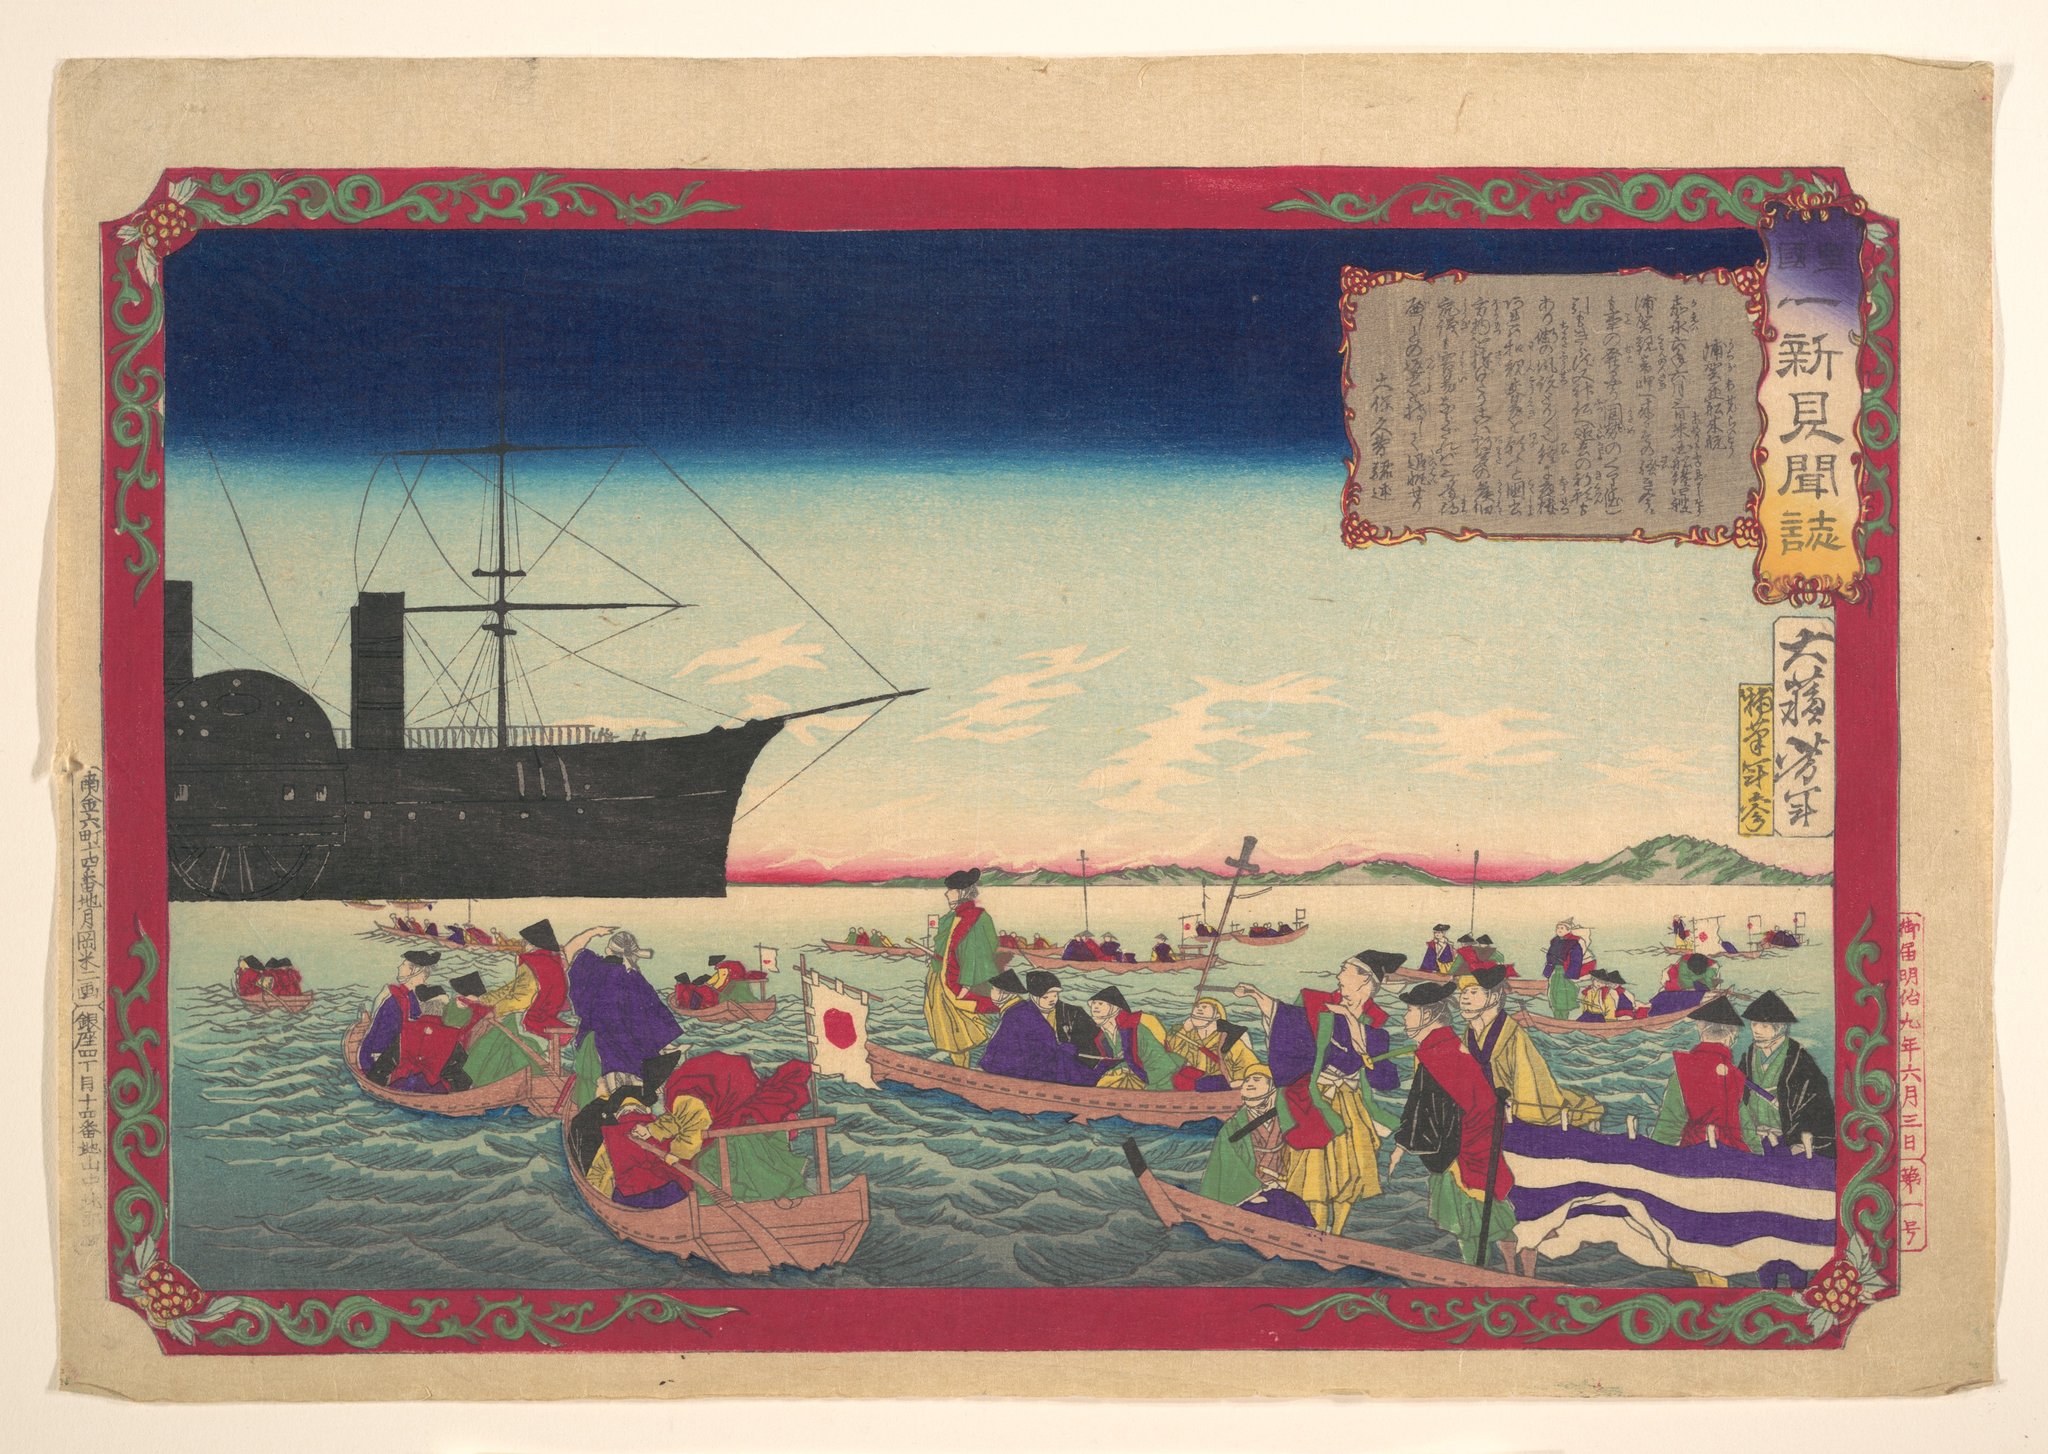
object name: print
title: Chronicle of the Imperial Restoration (Kōkoku isshin kenbunshi)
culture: japanese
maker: tsukioka yoshitoshi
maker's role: artist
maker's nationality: japanese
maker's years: 1839-1892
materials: ink, paper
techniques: woodblock print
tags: human figures,boats,ships